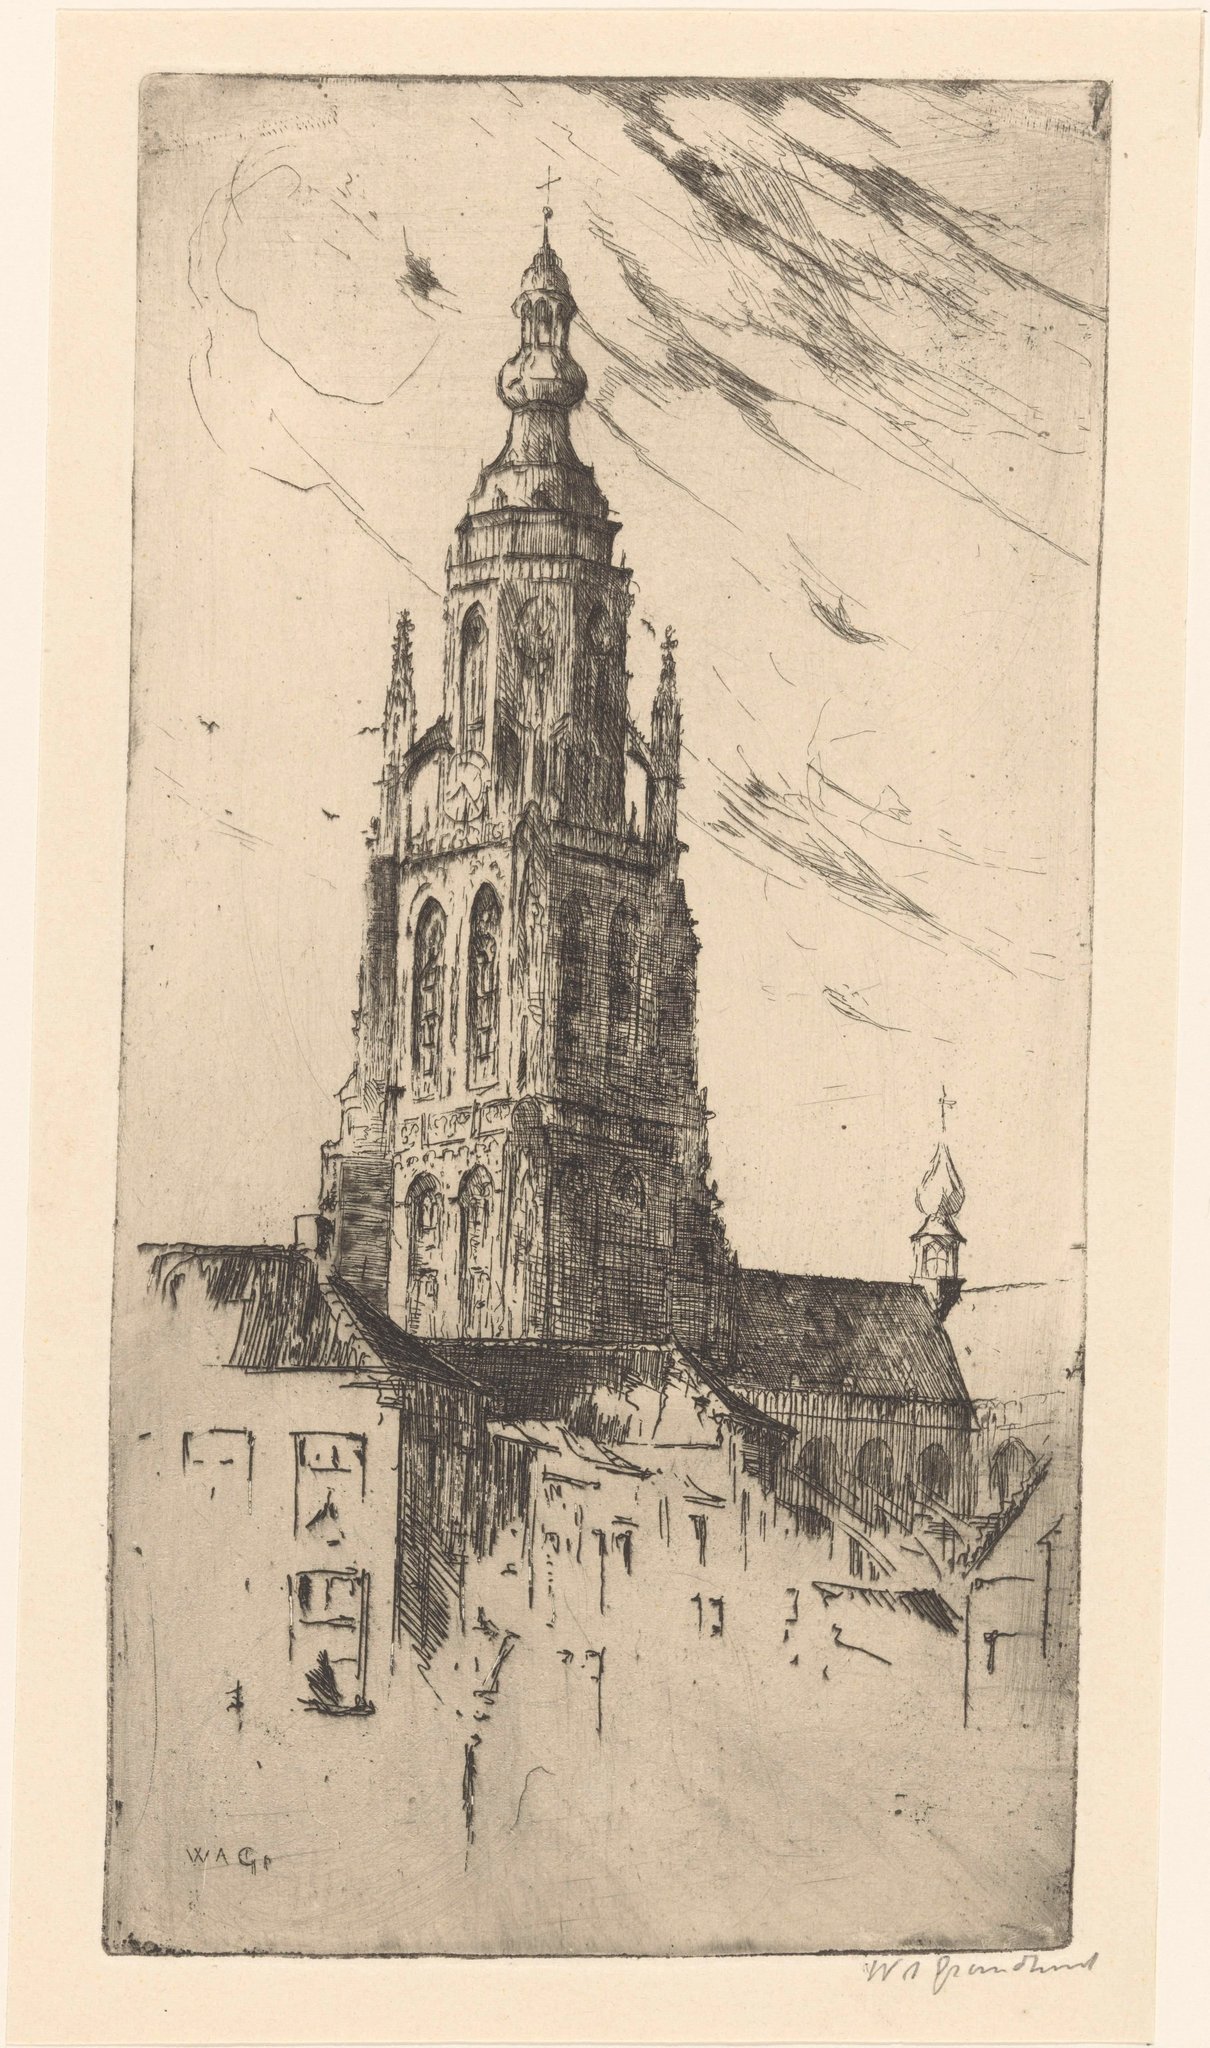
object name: print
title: Nieuwe Kerk in Delft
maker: willem adrianus grondhout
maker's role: draughtsman, painter, print maker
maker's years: 1878-1934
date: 1888-1931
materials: paper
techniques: etching, intaglio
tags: parts of church exterior and annexes: tower